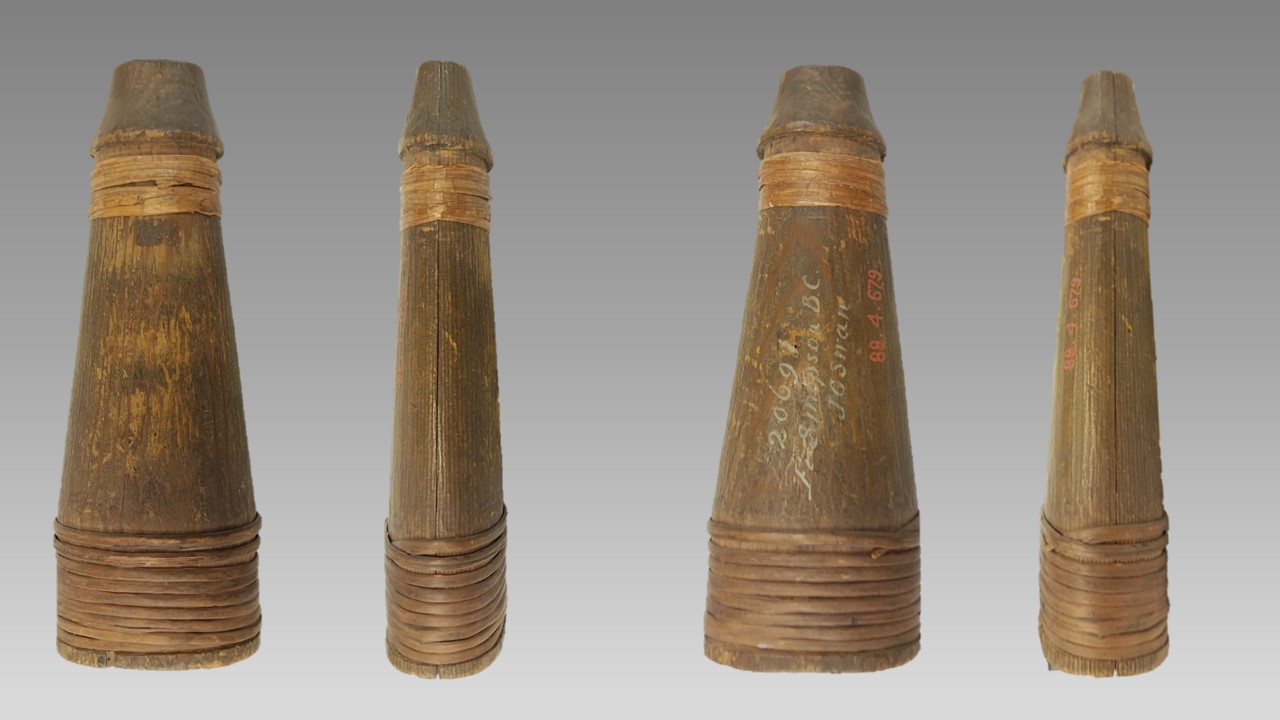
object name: reed pipe three double reed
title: Reed Pipe (triple)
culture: native american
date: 1801-1900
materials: wood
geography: canada